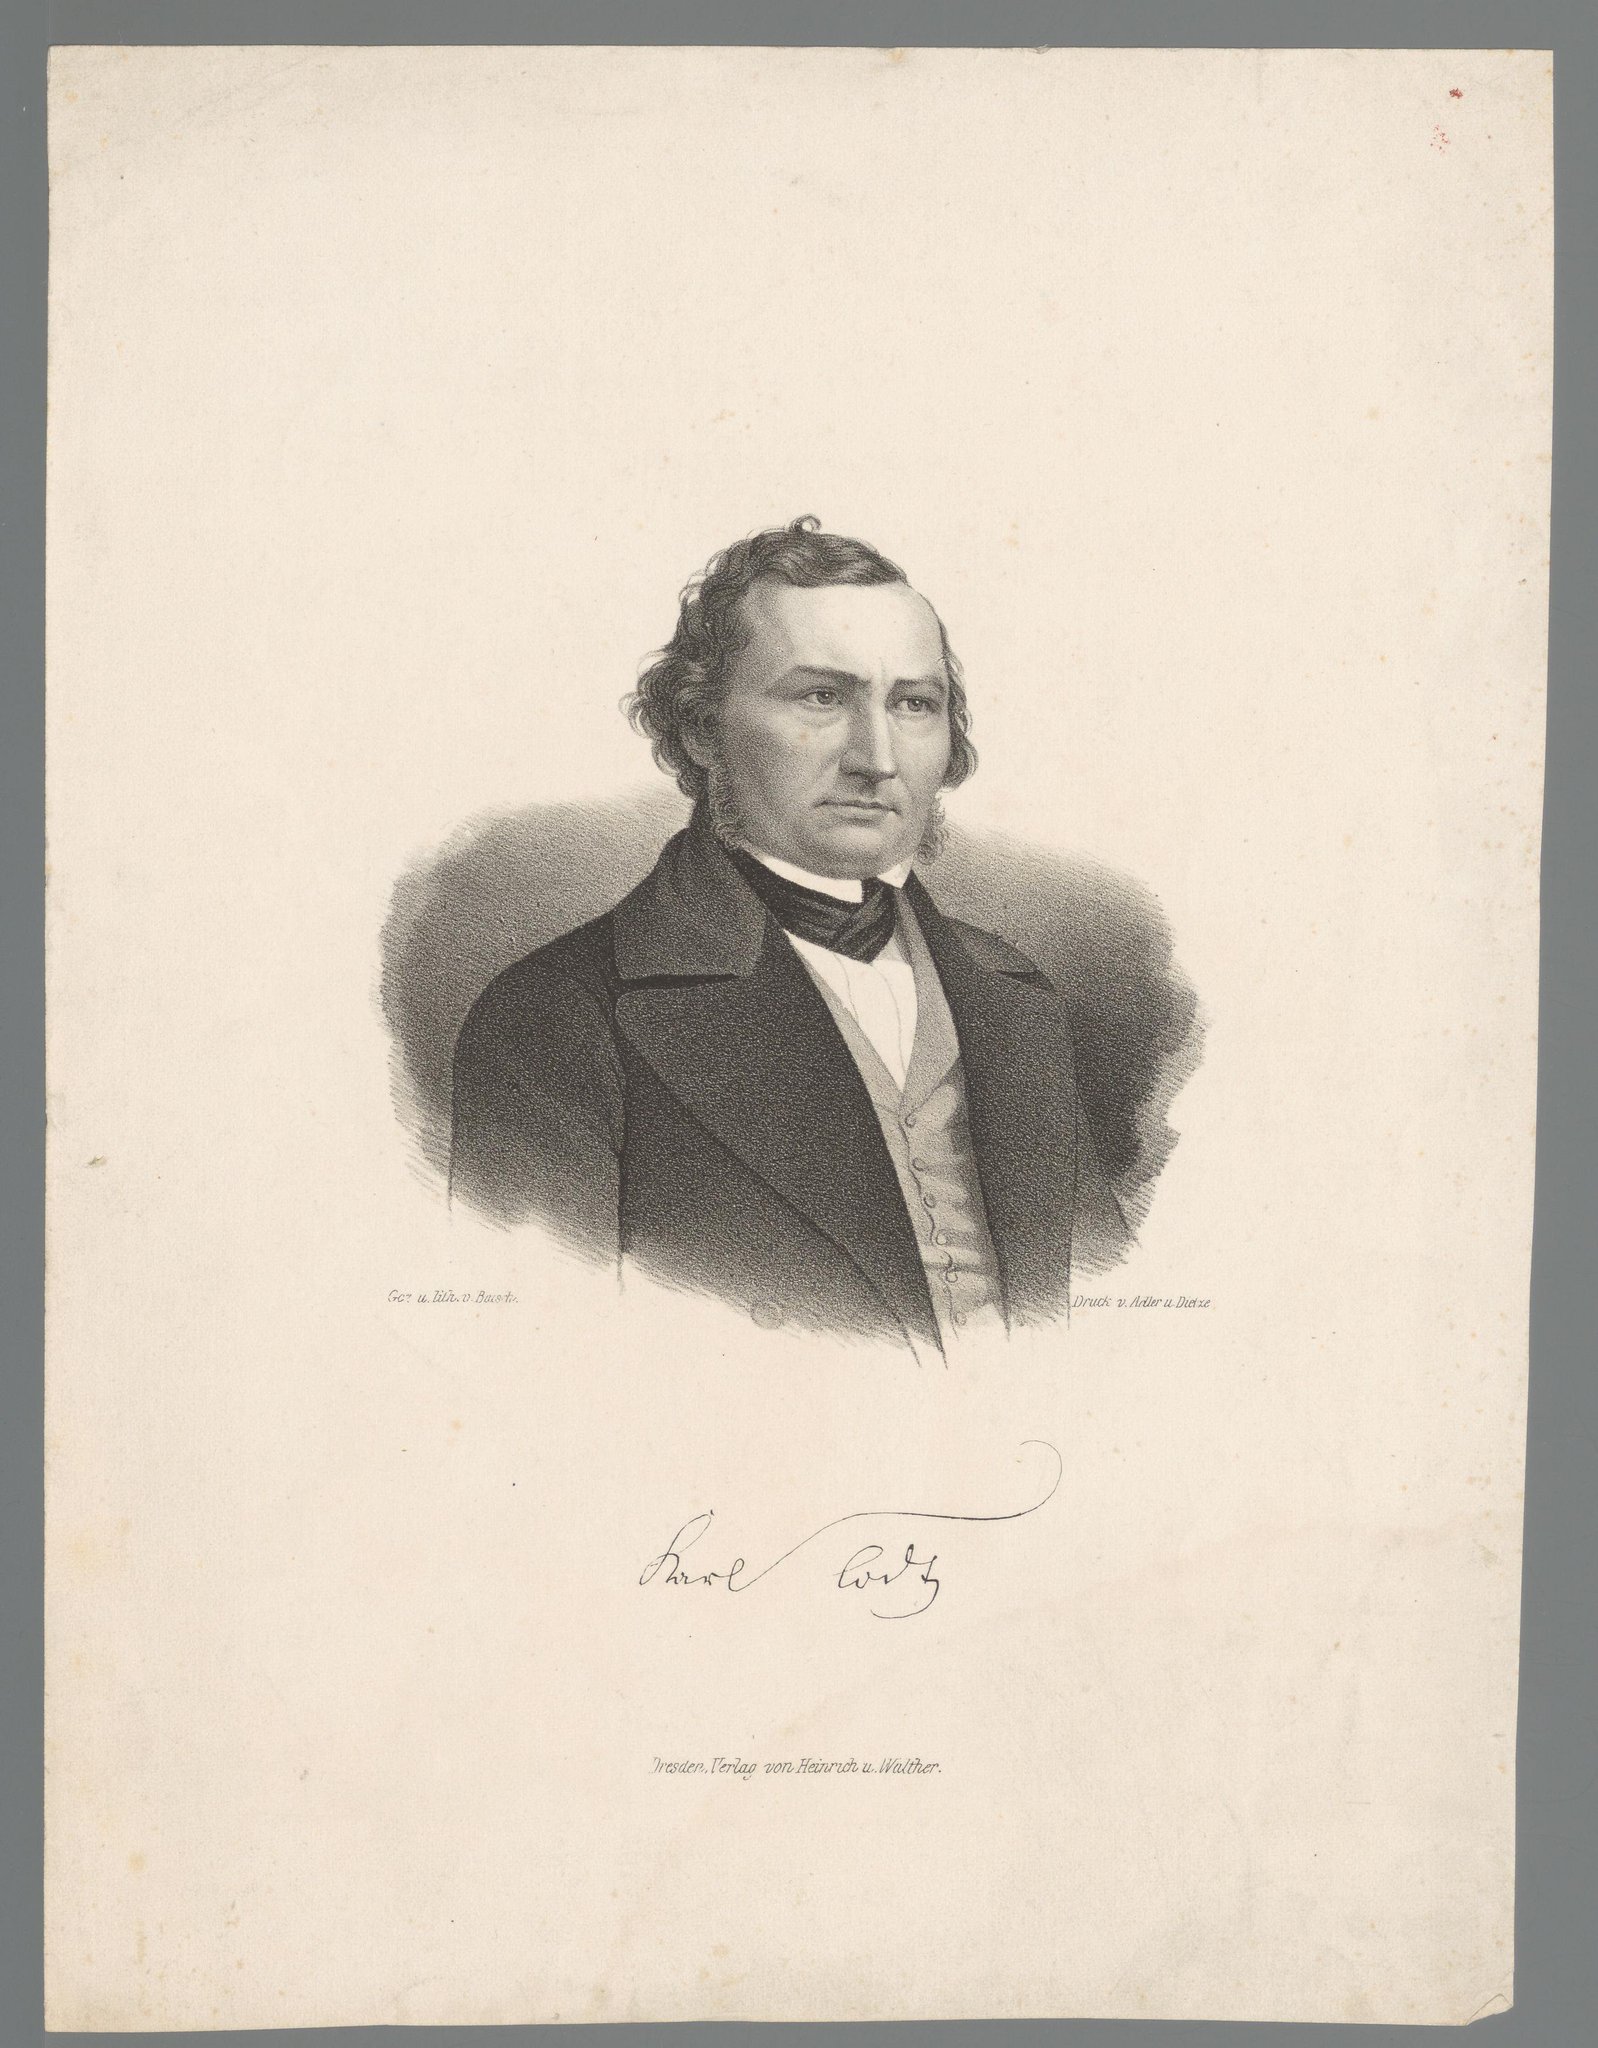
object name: print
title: Portret van Karl Gotthelf Todt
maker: wilhelm heinrich gottlieb baisch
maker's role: print maker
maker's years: 1805-1864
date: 1815-1864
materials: paper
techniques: lithograph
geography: dresden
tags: politician, historical persons, politician, e.g. party leader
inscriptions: collector's mark: Lugt 2228